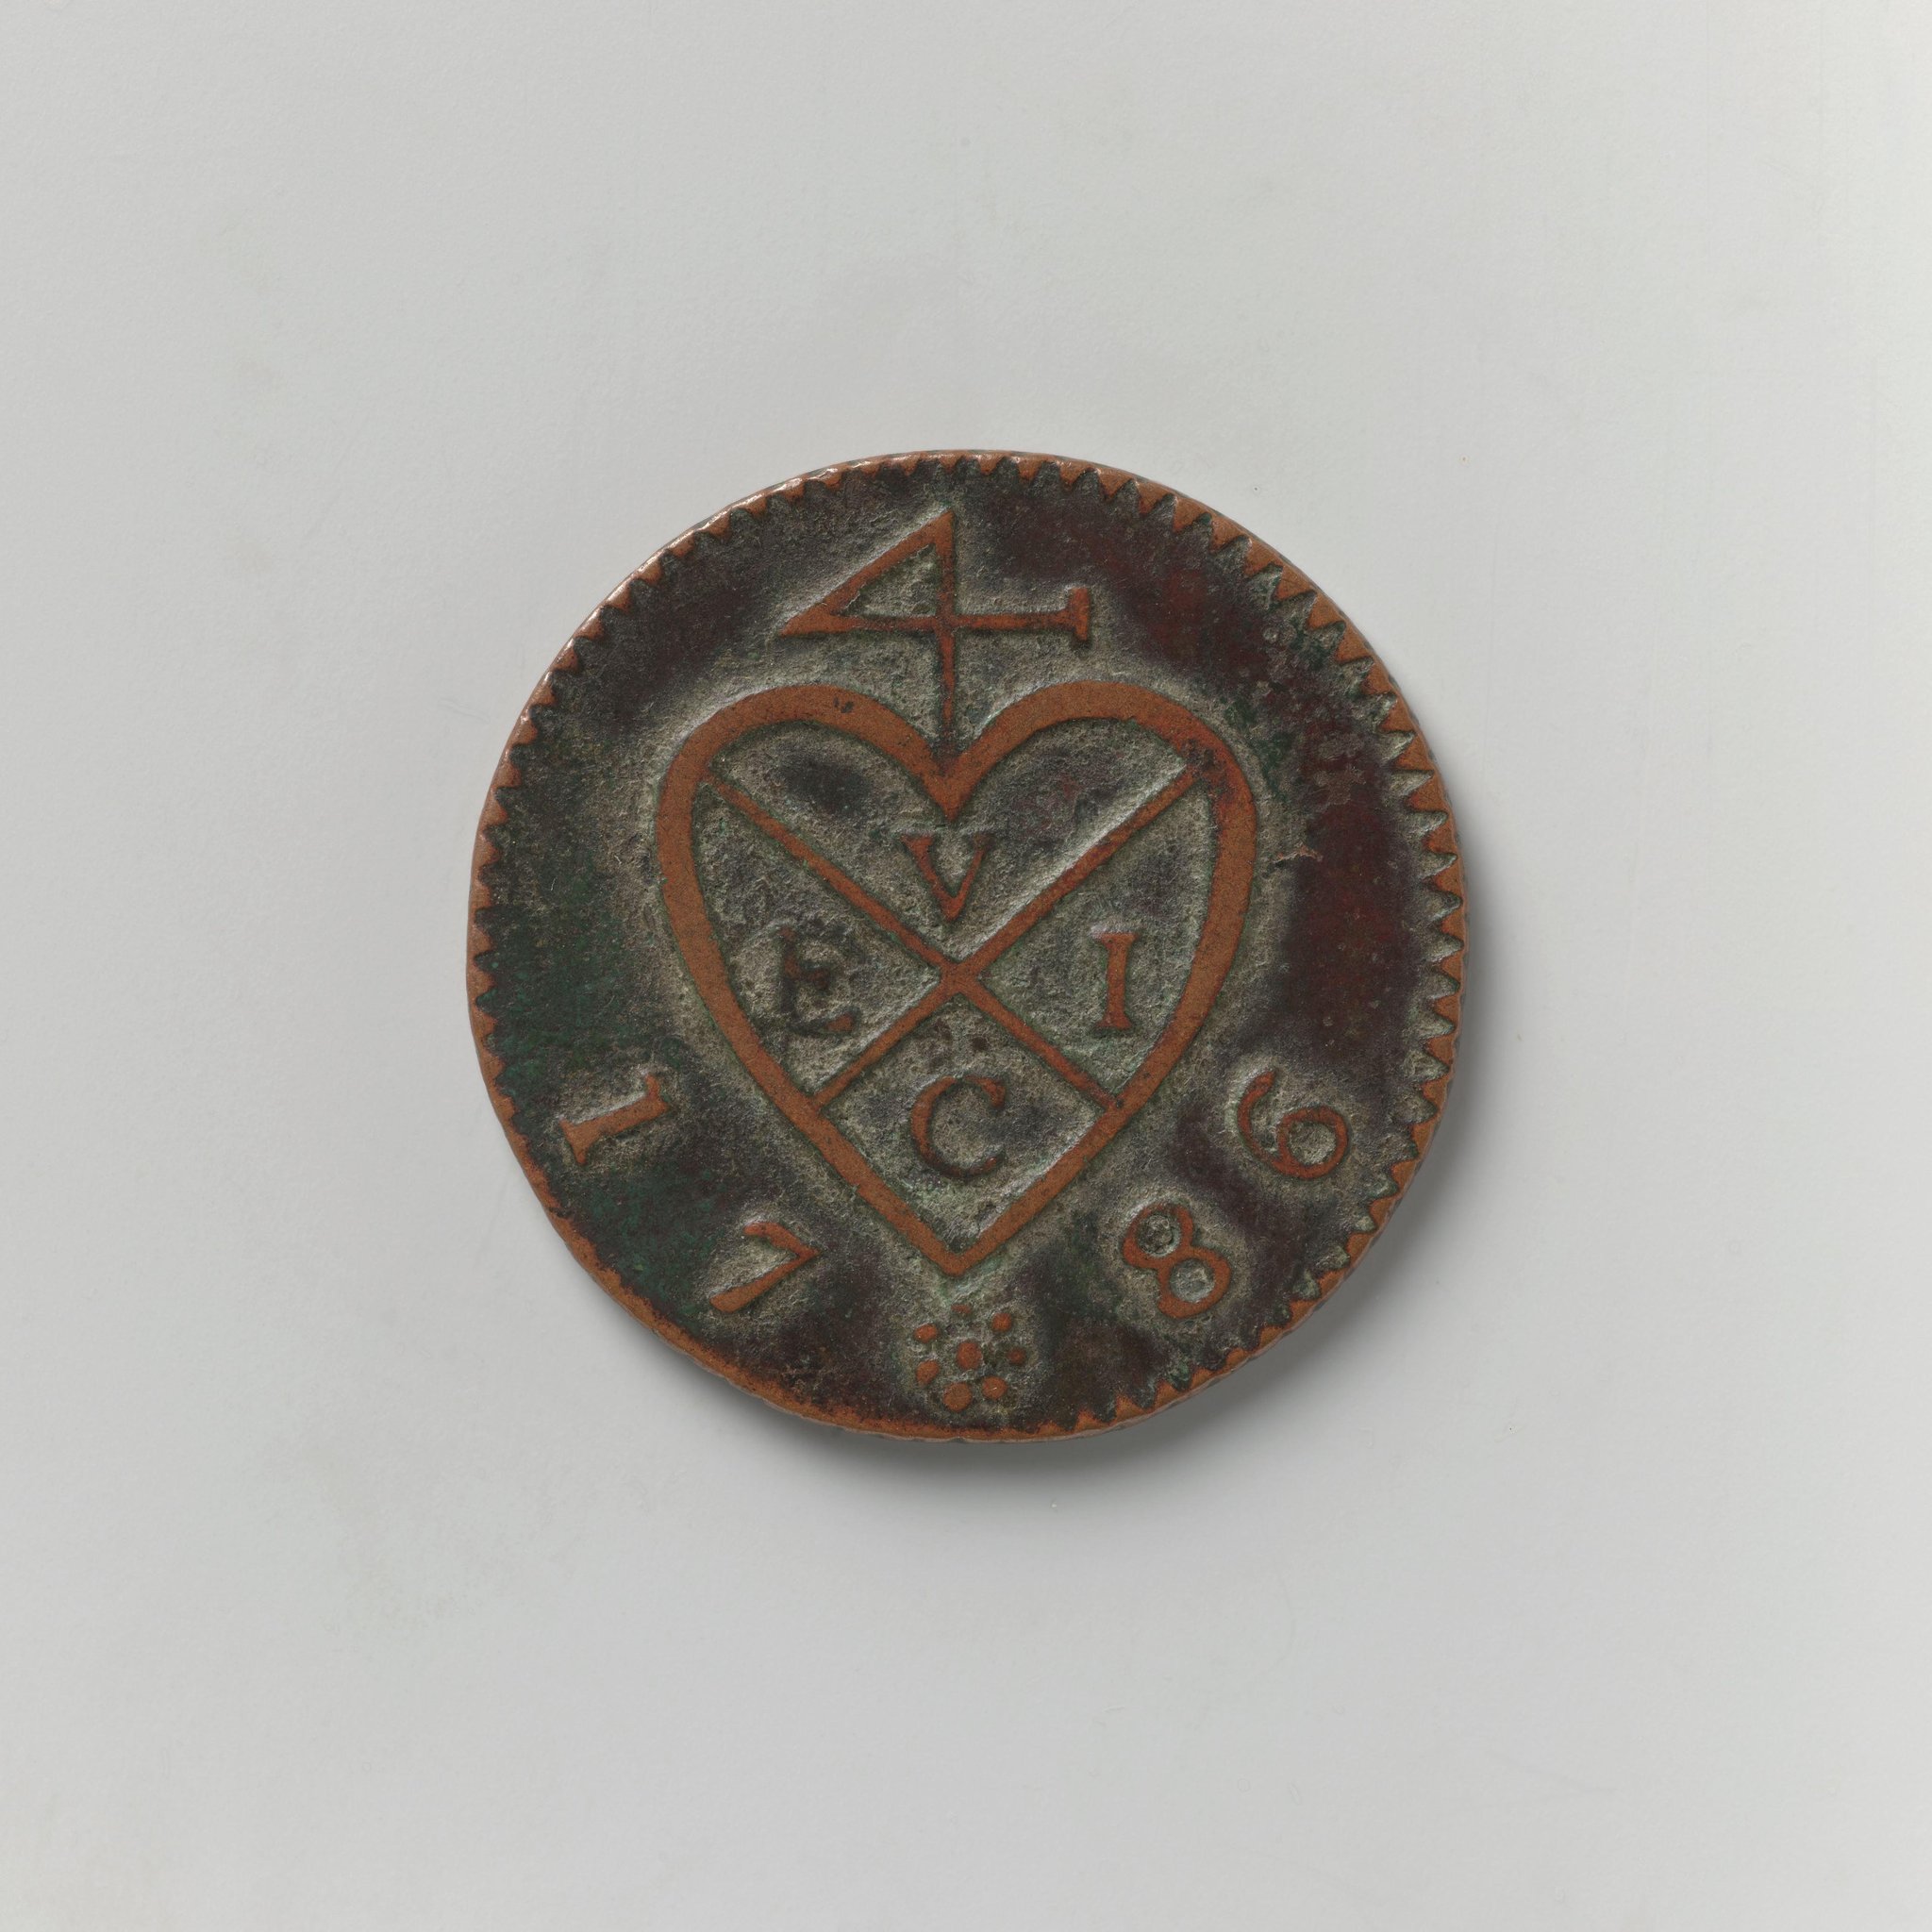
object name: coin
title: Kepeng van Engels Sumatra, Benkoelen,1786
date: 1786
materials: copper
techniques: striking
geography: birmingham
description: Koperen munt. Voorzijde: monogram van de Engelse Oostindische Compagnie, waaromheen jaartal. Keerzijde: op een regel waarde-aanduiding in het Maleis: sa kepeng in Arabische lettertekens. Daarboven aanduiding: 1 in Arabische cijfers en daaronder jaartal in Islamitische tijdsrekening en Arabische cijfers. Kabelrand.